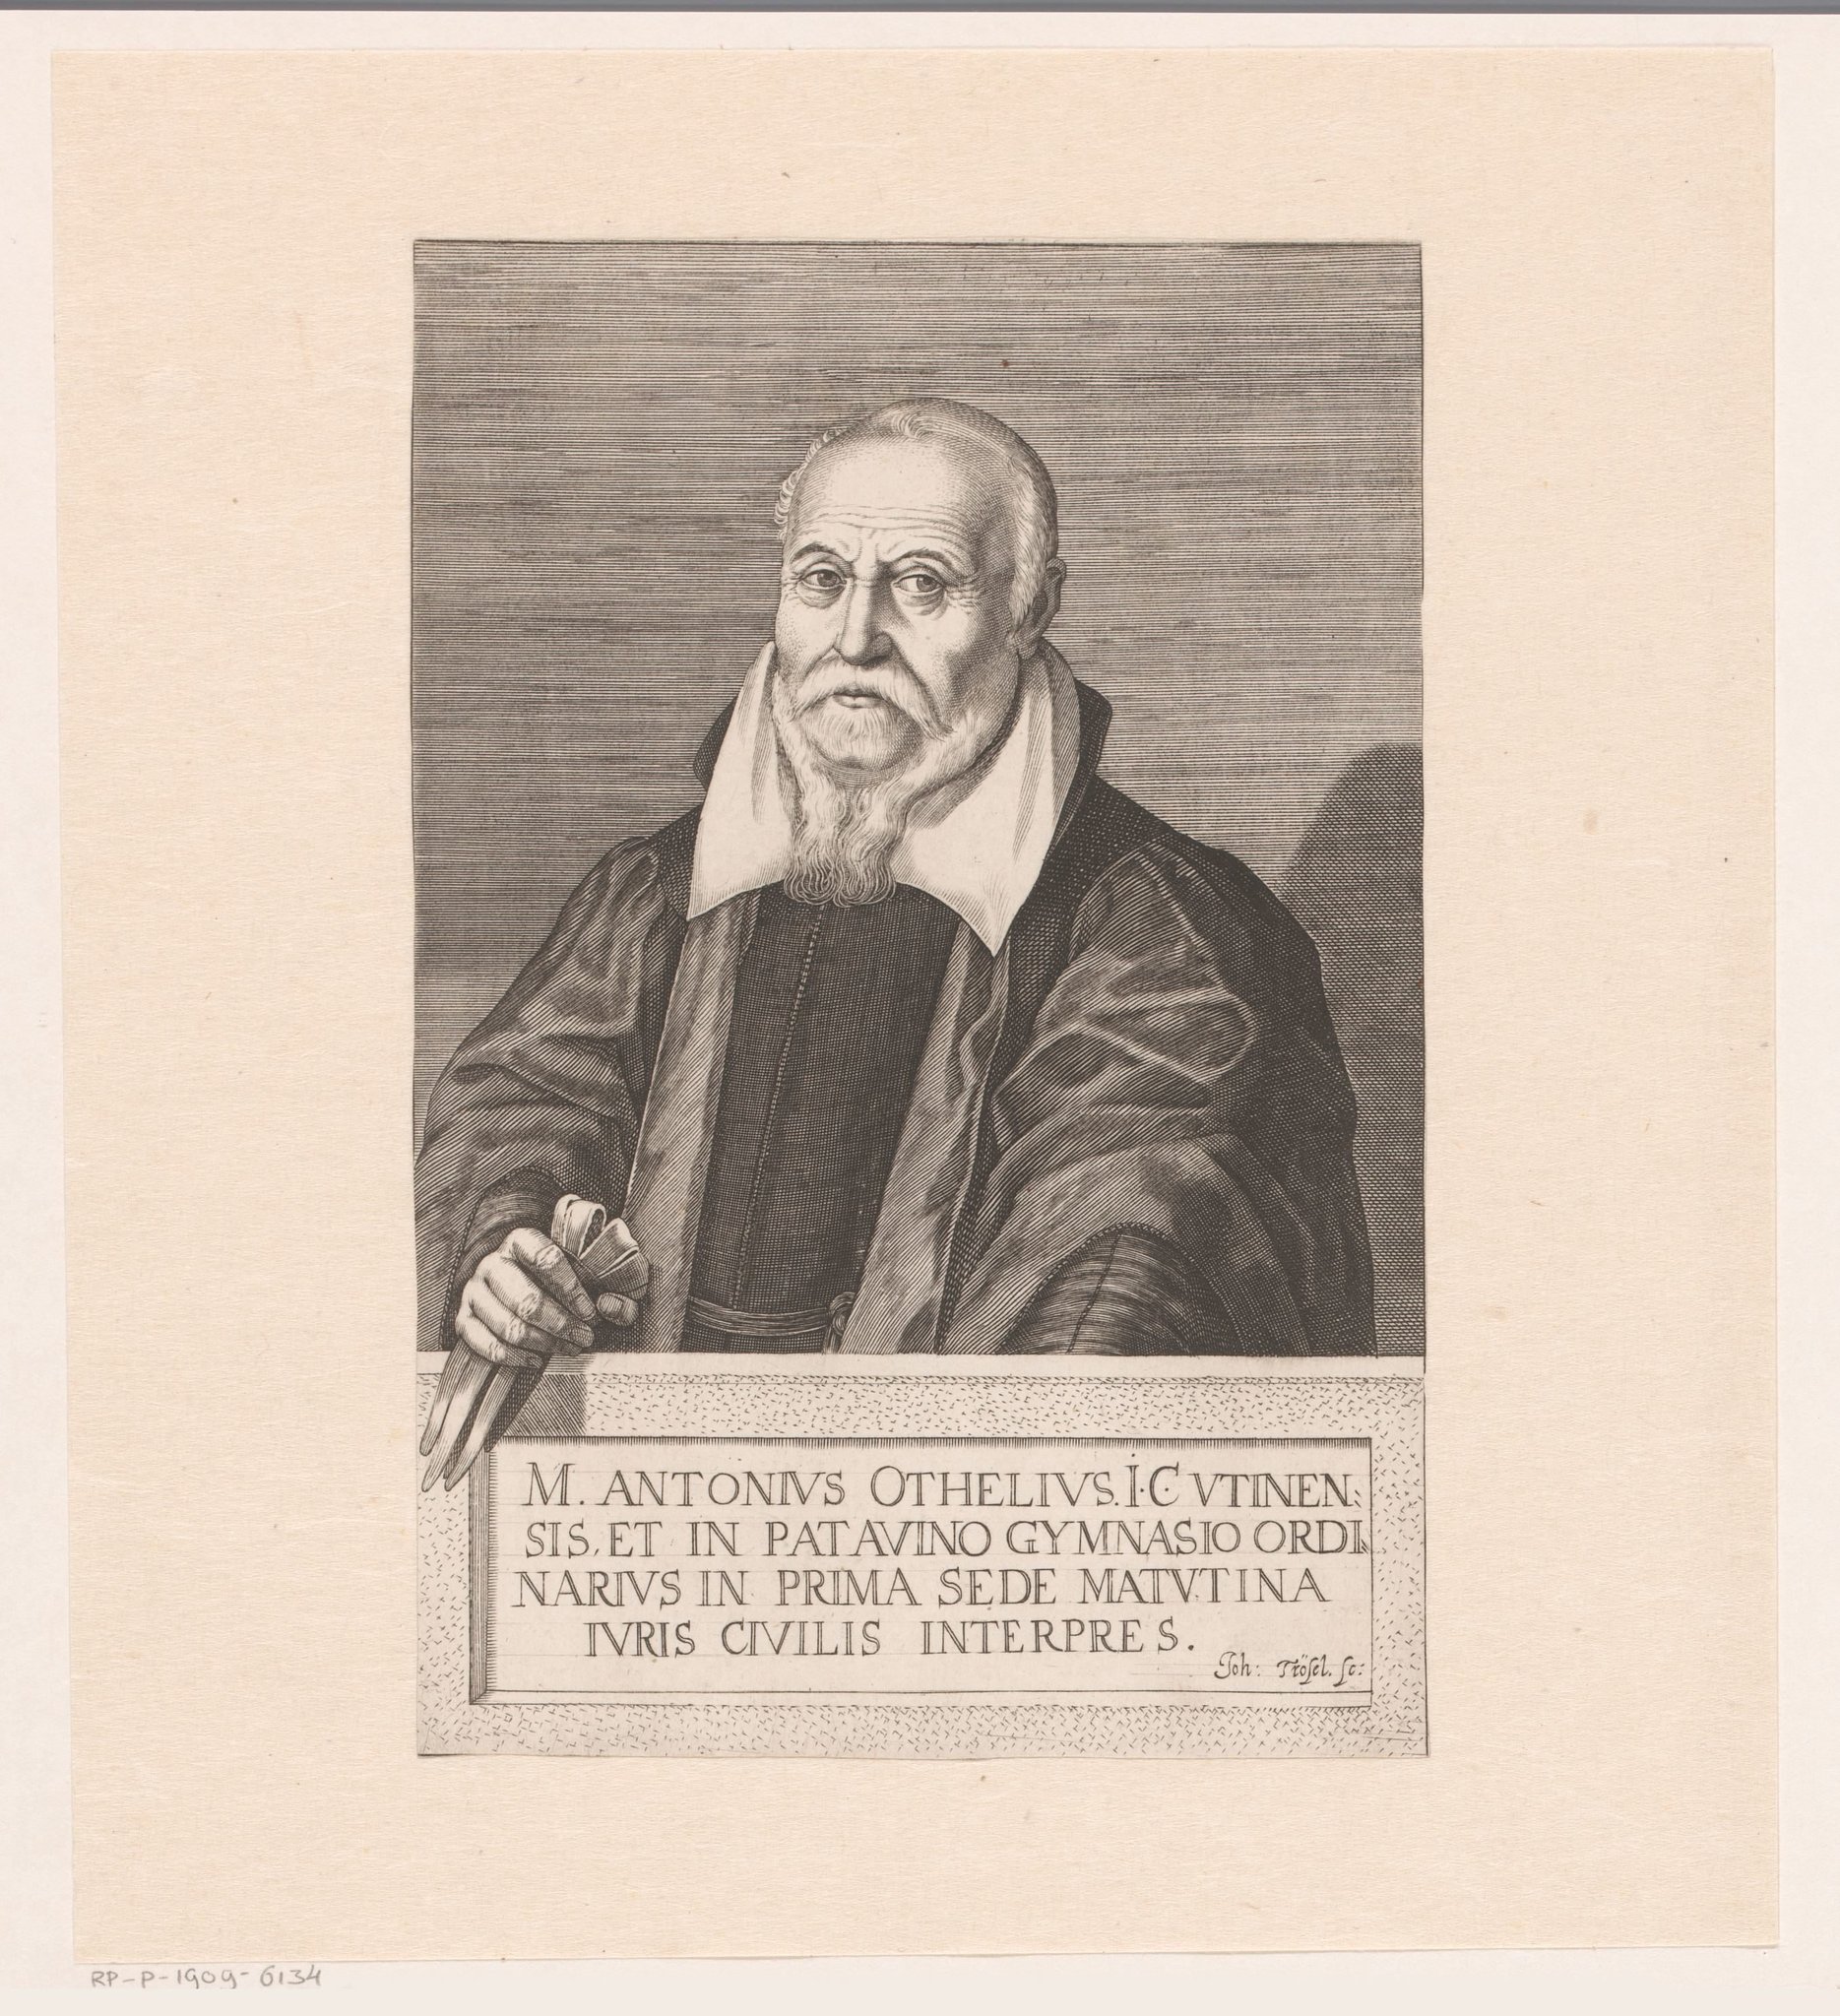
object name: print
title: Portret van Marco Antonio Ottelio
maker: hans troschel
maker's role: draughtsman, print maker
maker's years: 1585-1628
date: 1595-1628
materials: paper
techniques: engraving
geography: germany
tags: gloves, mittens, etc., historical persons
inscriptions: collector's mark: Lugt 2228